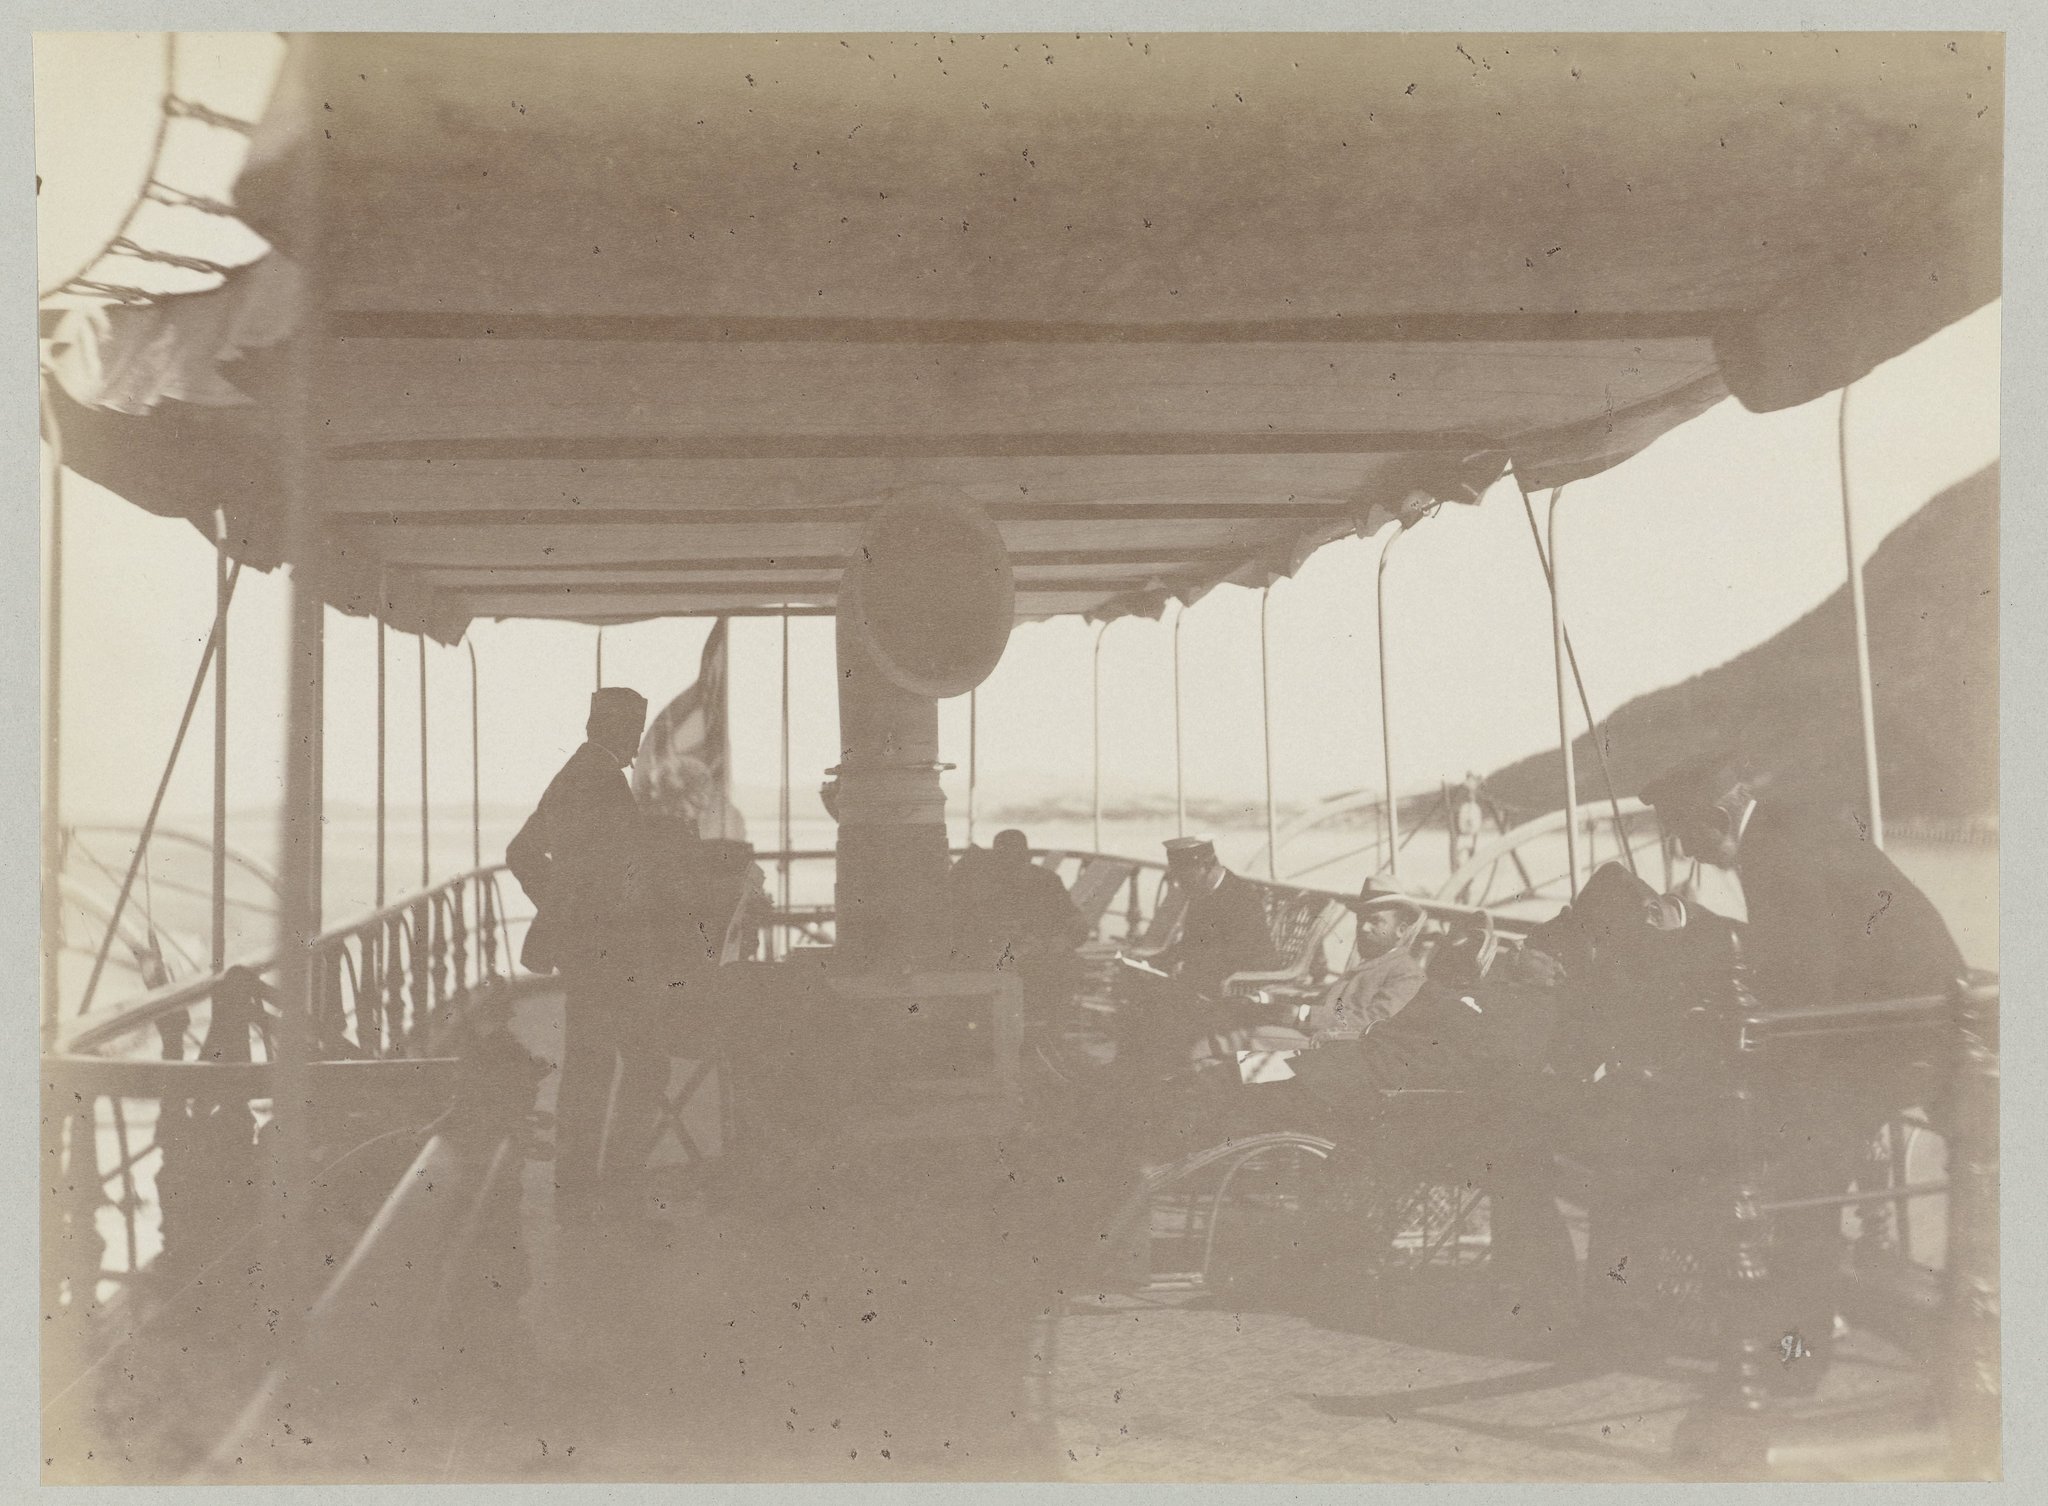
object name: photograph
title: Während der Fahrt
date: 1807-1889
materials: cardboard, paper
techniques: albumen print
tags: norway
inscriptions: number: ‘8’, number: ‘91’